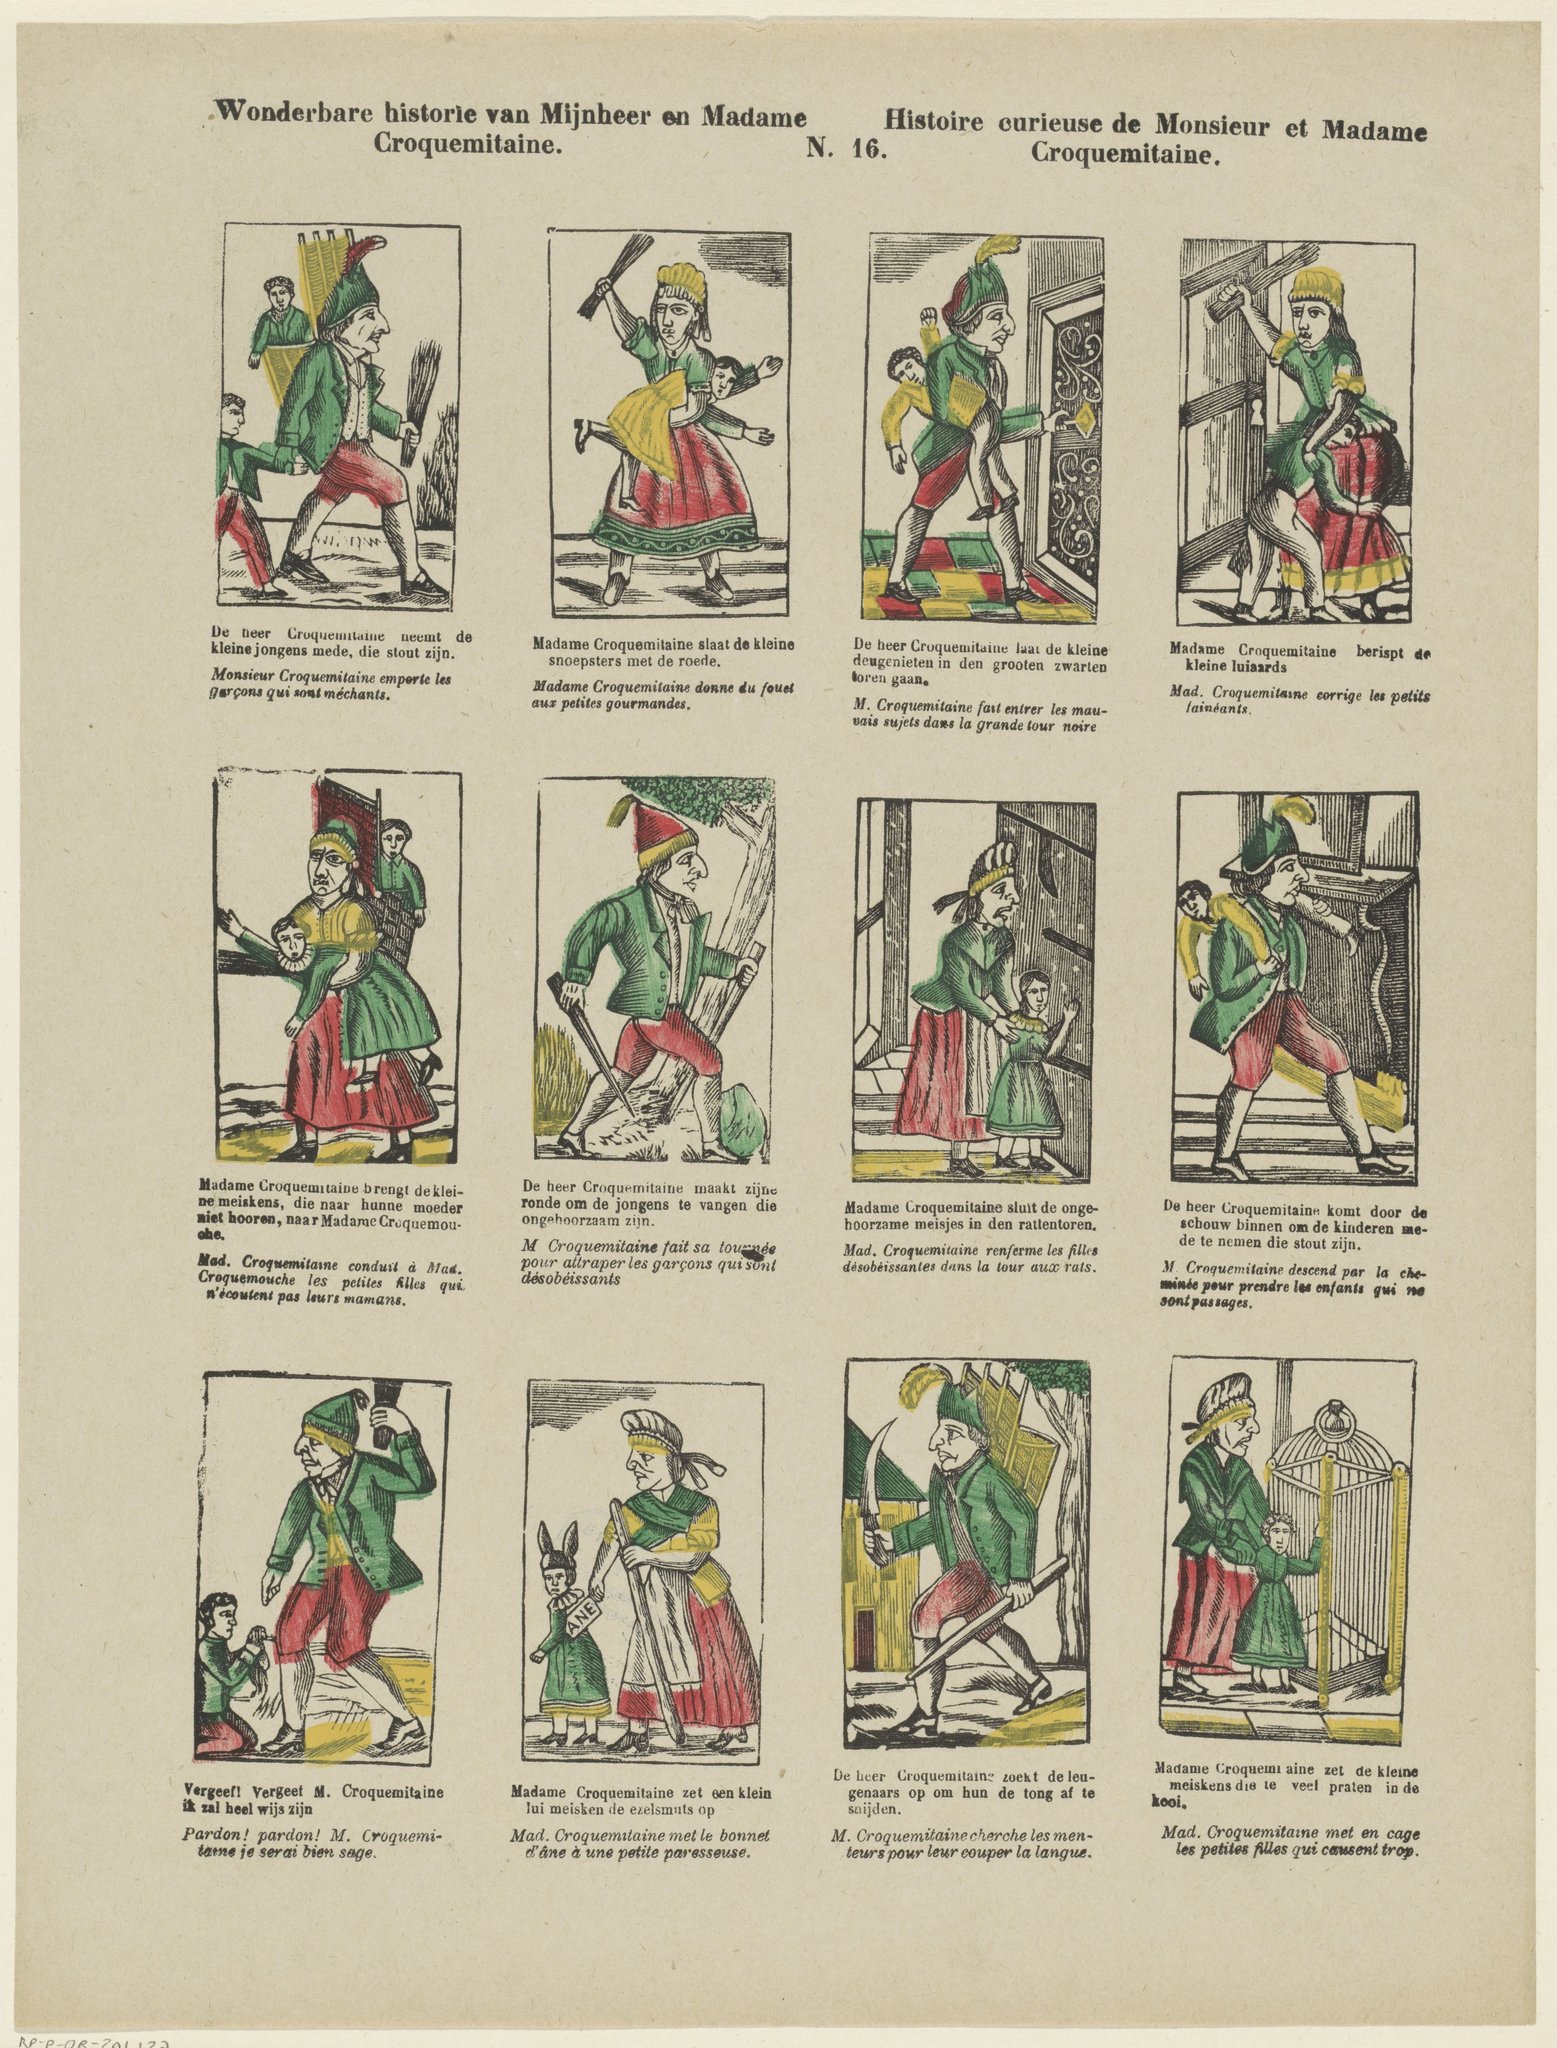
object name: print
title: Wonderbare historie van mijnheer en madame Croquemitaine / Histoire curieuse de monsieur et madame Croquemitaine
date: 1866-1902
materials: paper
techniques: colour, letterpress printing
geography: turnhout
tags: correction of naughty children, bad behaviour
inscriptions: collector's mark: Lugt 2760, collector's mark: ‘Edw. Ipers / Oever 27, / Antwerpen.’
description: Blad met 12 voorstellingen over het leven van meneer en mevrouw Croquemitaine die stoute kinderen straffen. Onder elke afbeelding een tweeregelig vers in het Nederlands en in het Frans. Genummerd midden boven: N. 16.